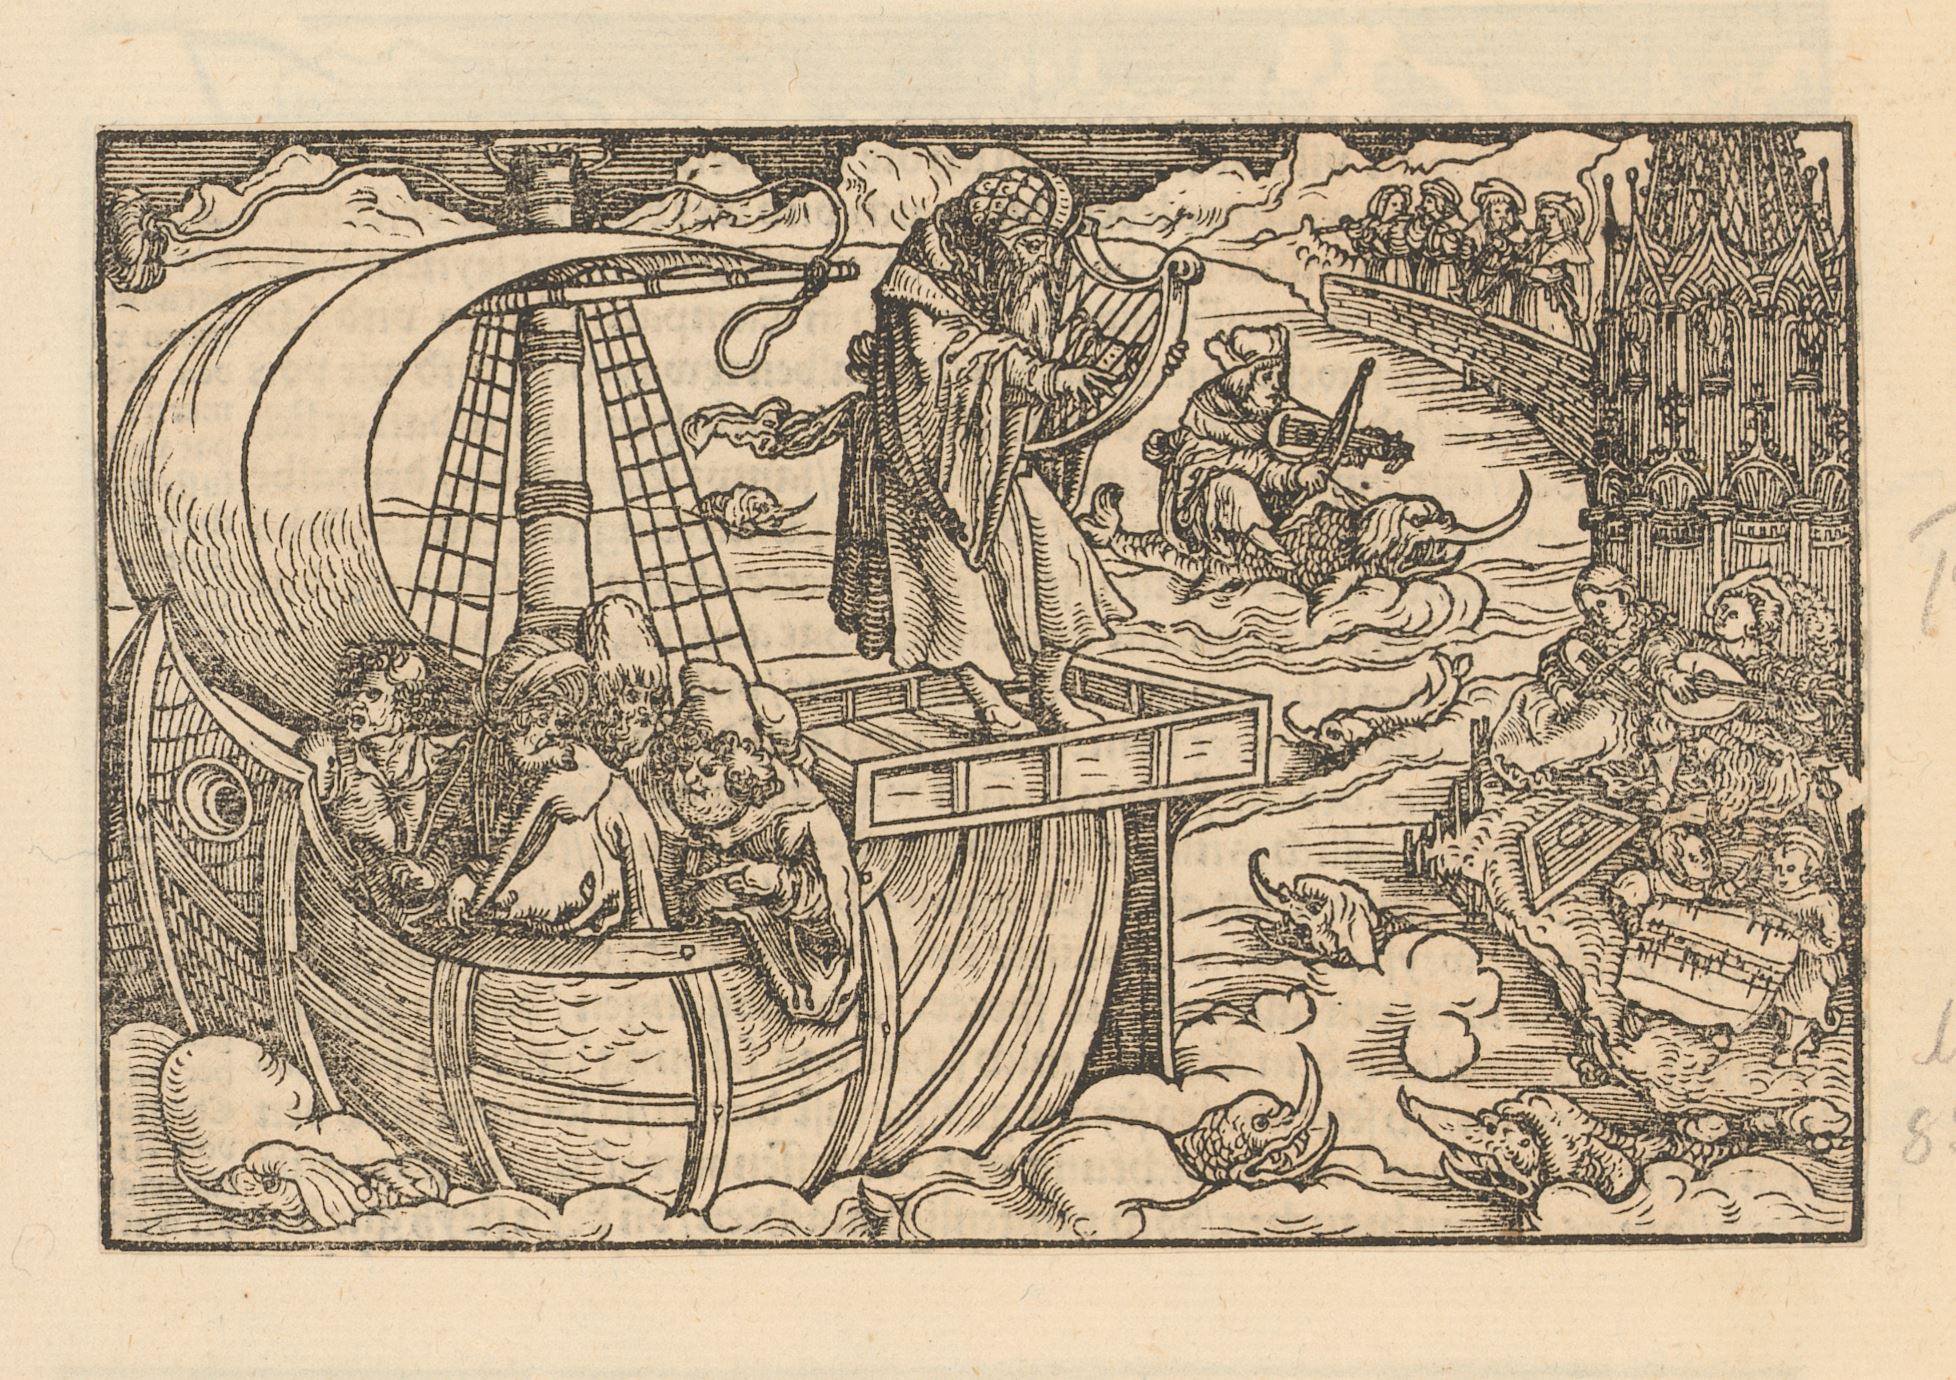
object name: album leaf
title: Schip met een harp spelende man op de boeg en een luit spelende man in zee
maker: Anonymous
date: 1514-1532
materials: paper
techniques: letterpress printing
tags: swimming mammals: dolphin, veneration of palaemon: carried on a dolphin's back, he arrives at corinth, where sisyphus receives him with divine honours (philostratus, imagines ii 16), harp - cc - out of doors, (story of) arion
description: Deze prent is gebruikt in: Petrarca, Francesco. Von der Artzney bayder Glück, des guten und widerwertigen: unnd weß sich ain yeder inn Gelück und Unglück halten sol (...). Augsburg: Heinrich Steiner, 1532. Deze uitgave is ook bekend onder de titel 'Trostspiegel in Glück und Unglück'. Mogelijk verbeeldt deze voorstelling het verhaal van Arion van Lesbos. Gezien de musicale verwelkoming bij de kust zou dit echter ook Palaemon op een dolfijn kunnen zijn. Mogelijk is het (fictieve) uiterlijk van de dolfijn deels gebaseerd op die van de narwal, een arctische tandwalvis welke behoort tot de familie van de grondeldolfijnen.